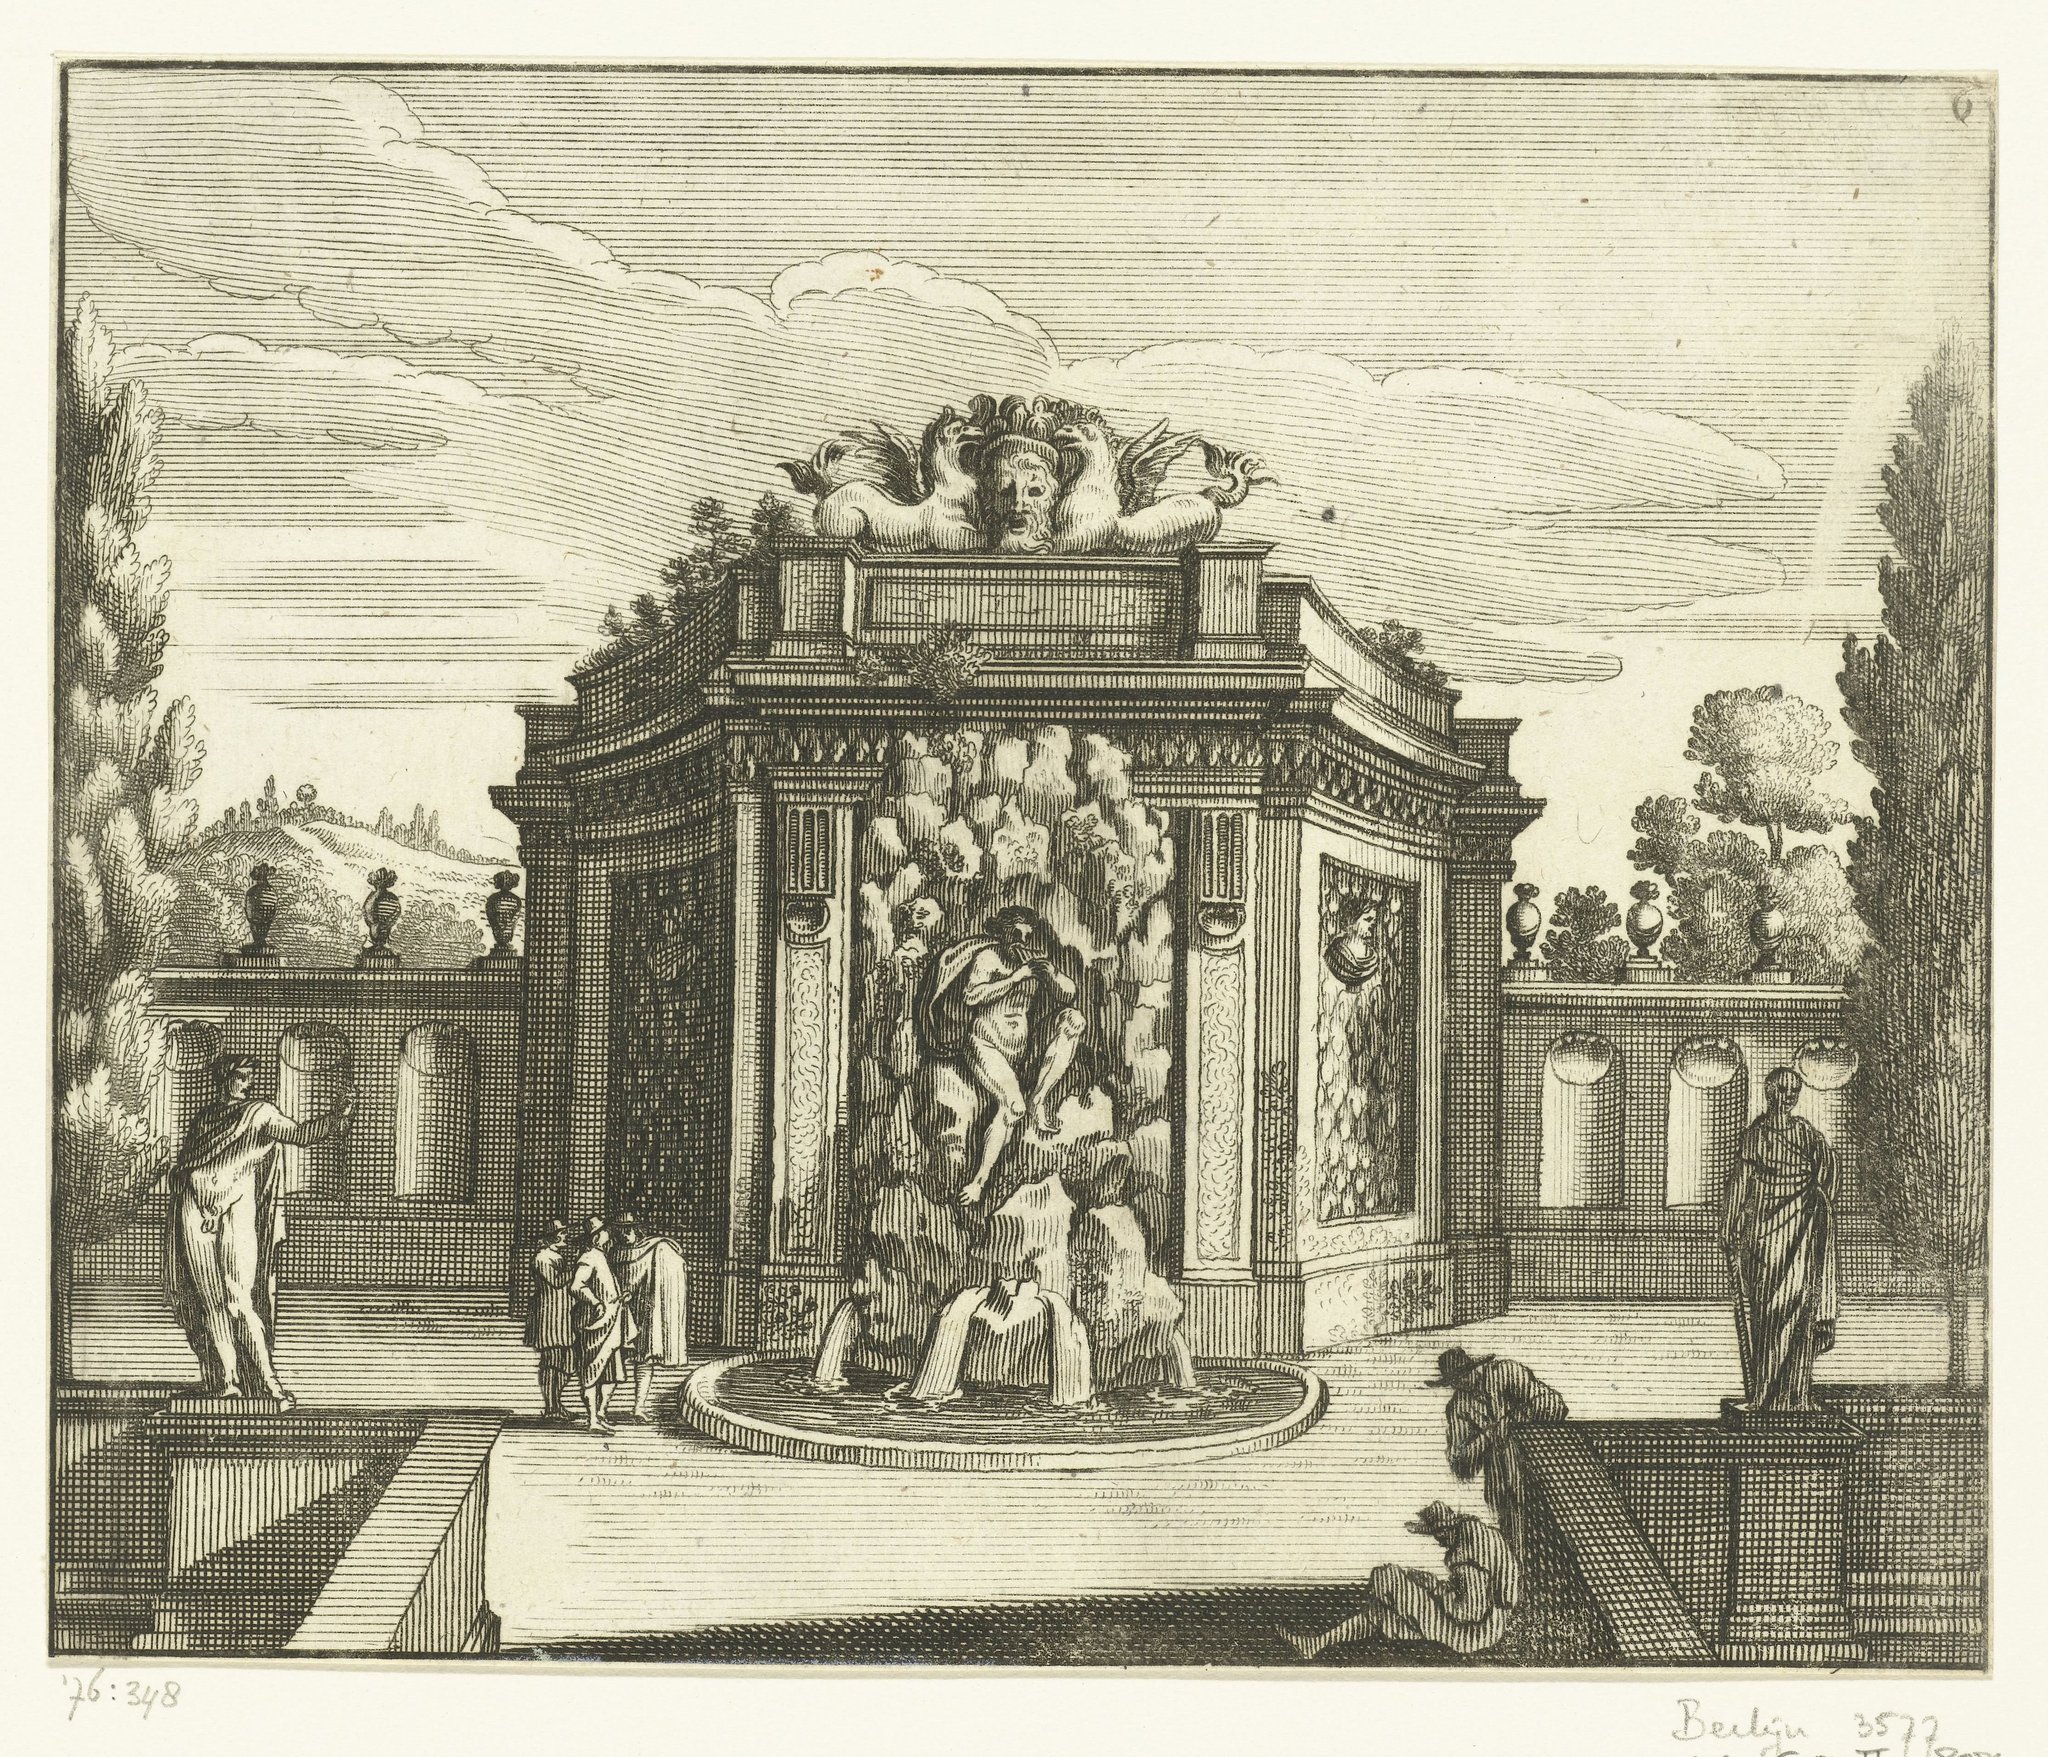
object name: ornament print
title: Architectura Curiosa Nova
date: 1664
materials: paper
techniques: etching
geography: nuremberg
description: Pan zit op een rotsformatie van de fontein en speelt op zijn fluit. Blad 6 uit deel IV van een serie bestaande uit 226 bladen, verdeeld over vier boeken, elk met een eigen titelblad.